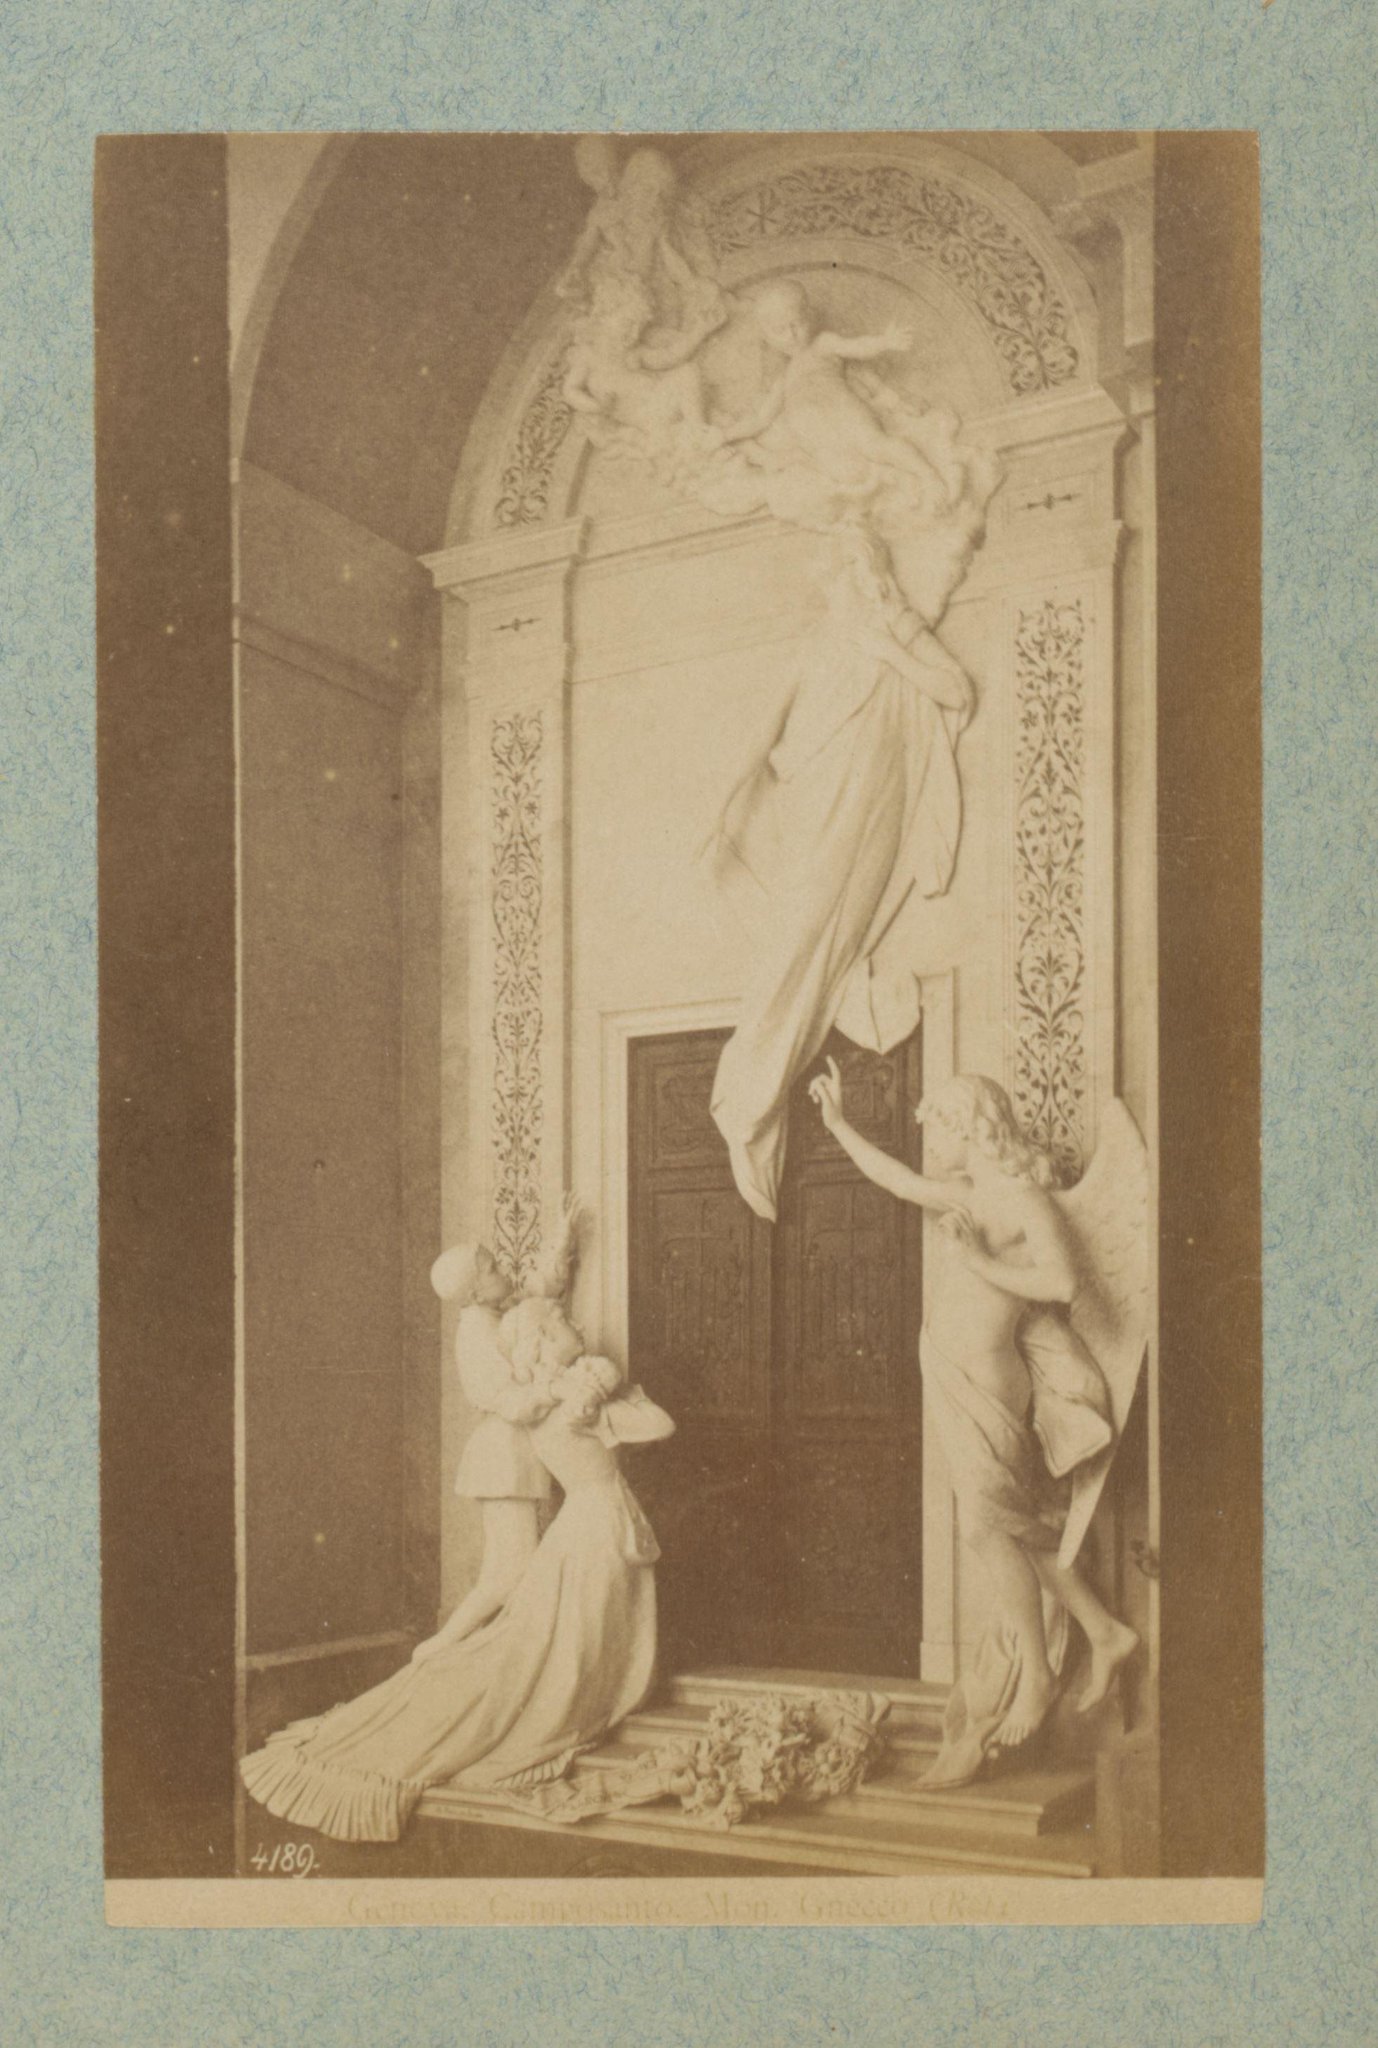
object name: photograph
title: Camposanto. Mon. Gnecco (Rota)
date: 1882-1890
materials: cardboard, paper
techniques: albumen print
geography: genoa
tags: sculpture, grave-building, monumental tomb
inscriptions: number: ‘4189.’, collector's mark: ‘VOSMAER’